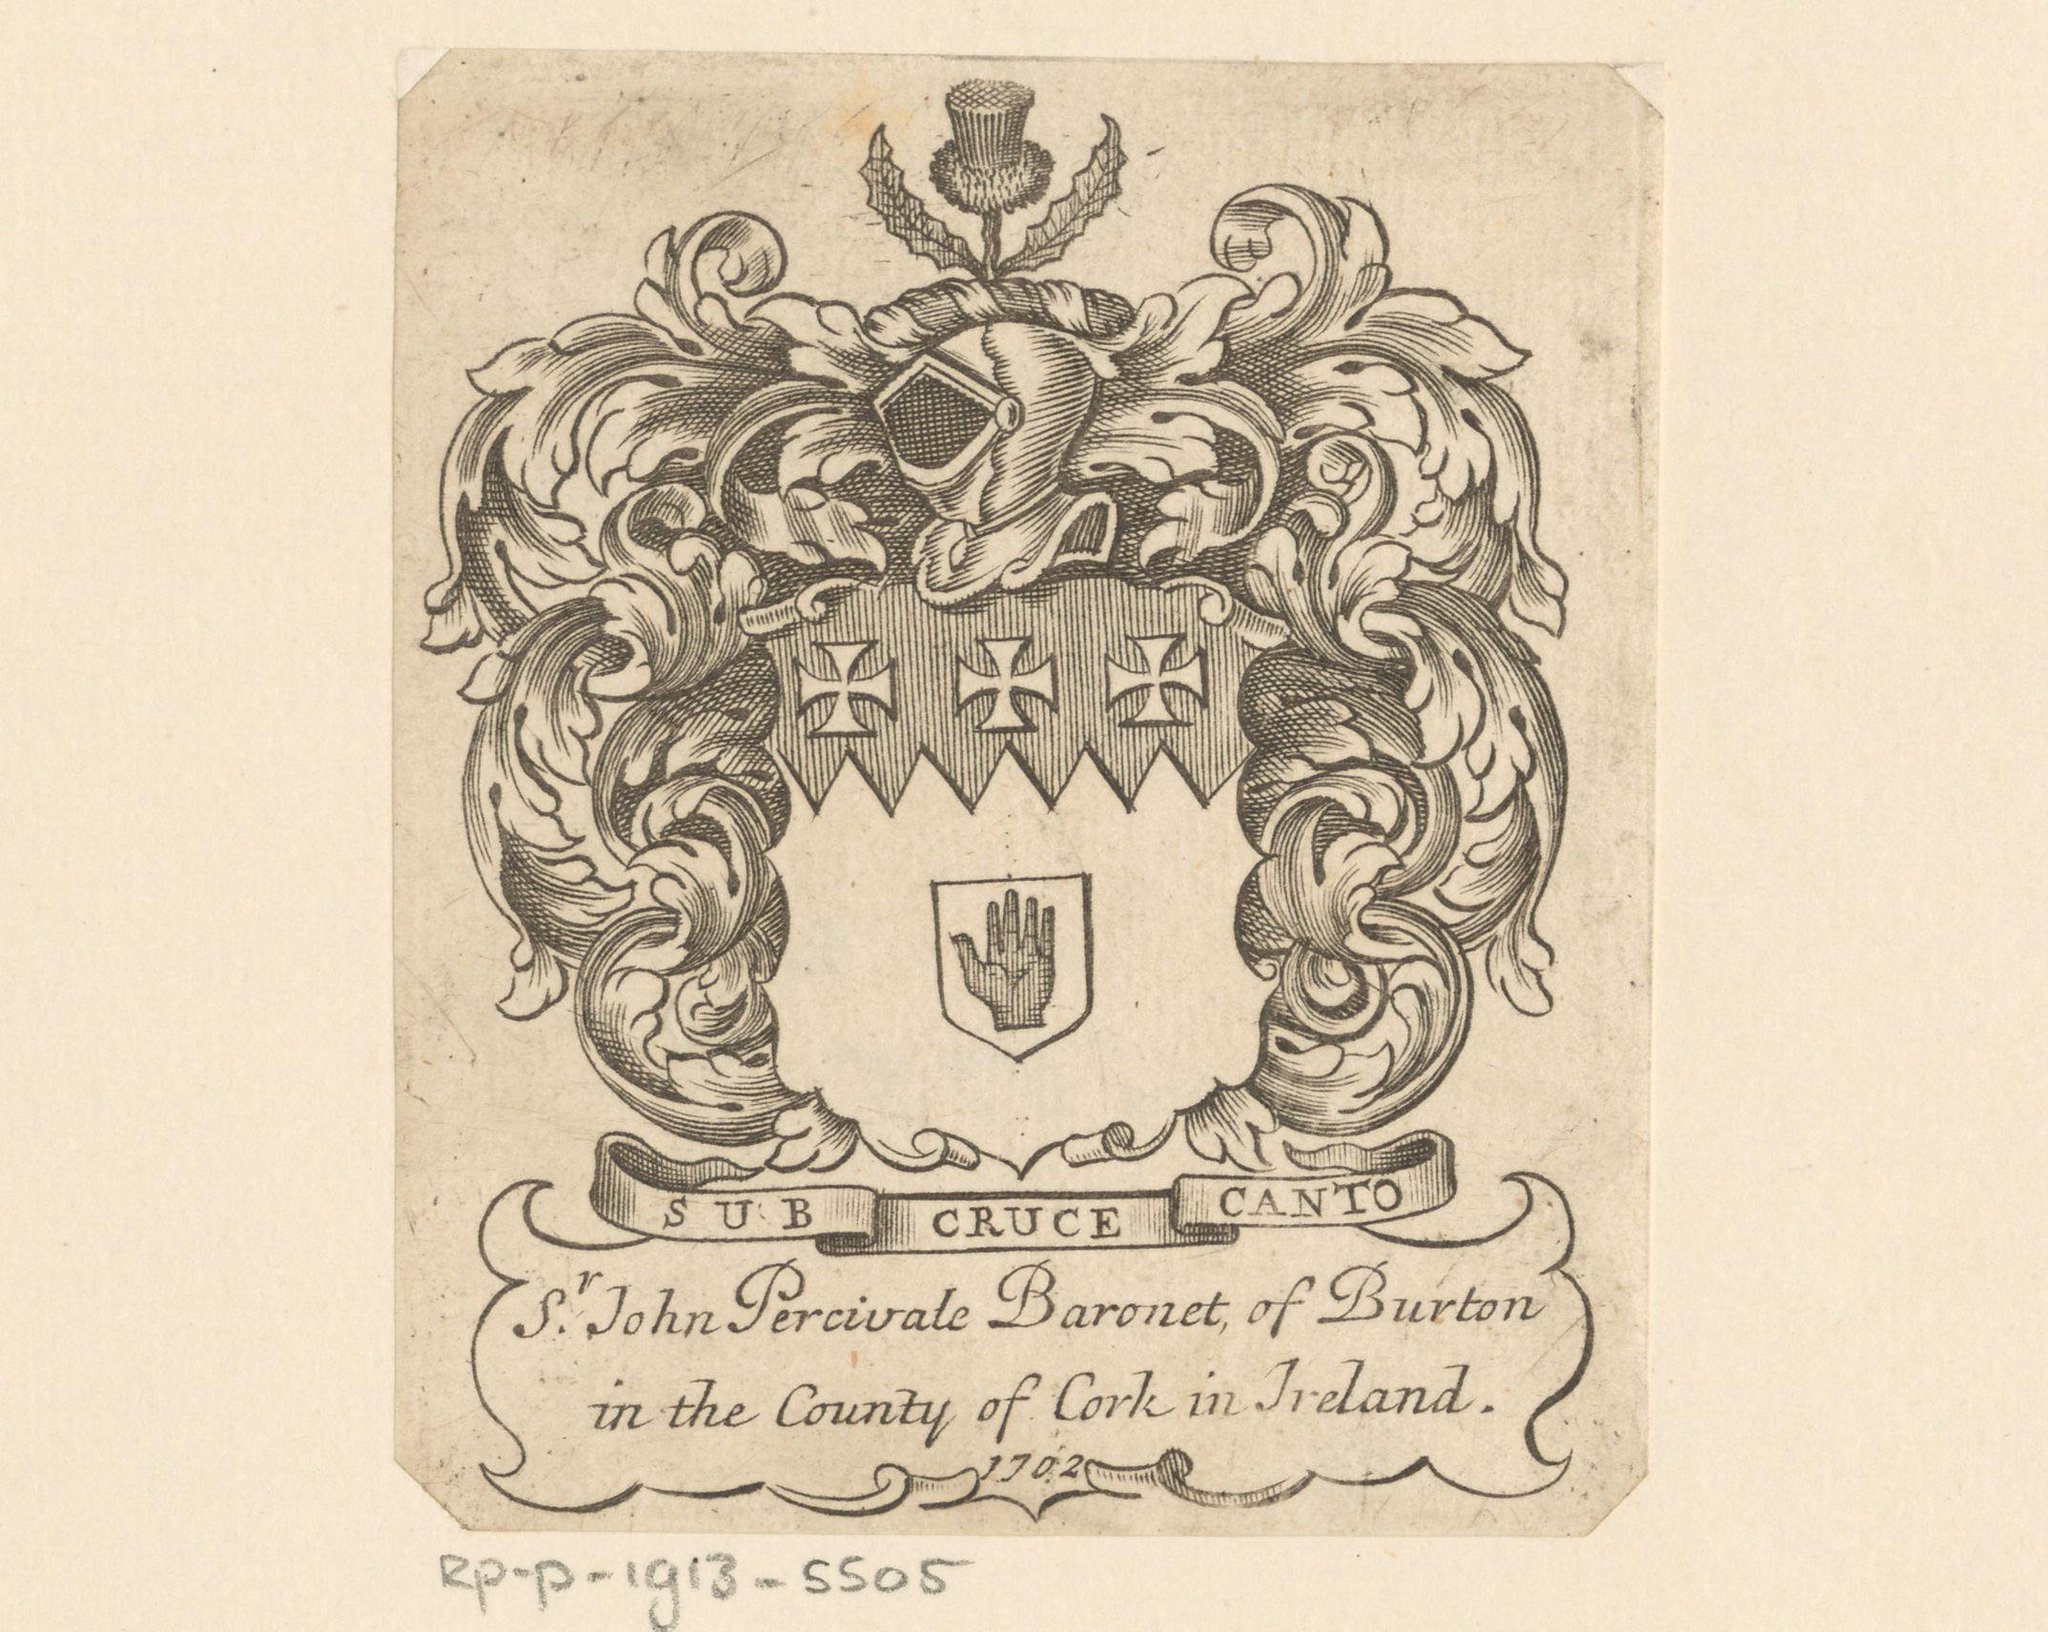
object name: bookplate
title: Sub cruce canto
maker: Anonymous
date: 1702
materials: paper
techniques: engraving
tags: politician, armorial bearing, heraldry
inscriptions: collector's mark: Lugt 2233, collector's mark: Lugt 2760